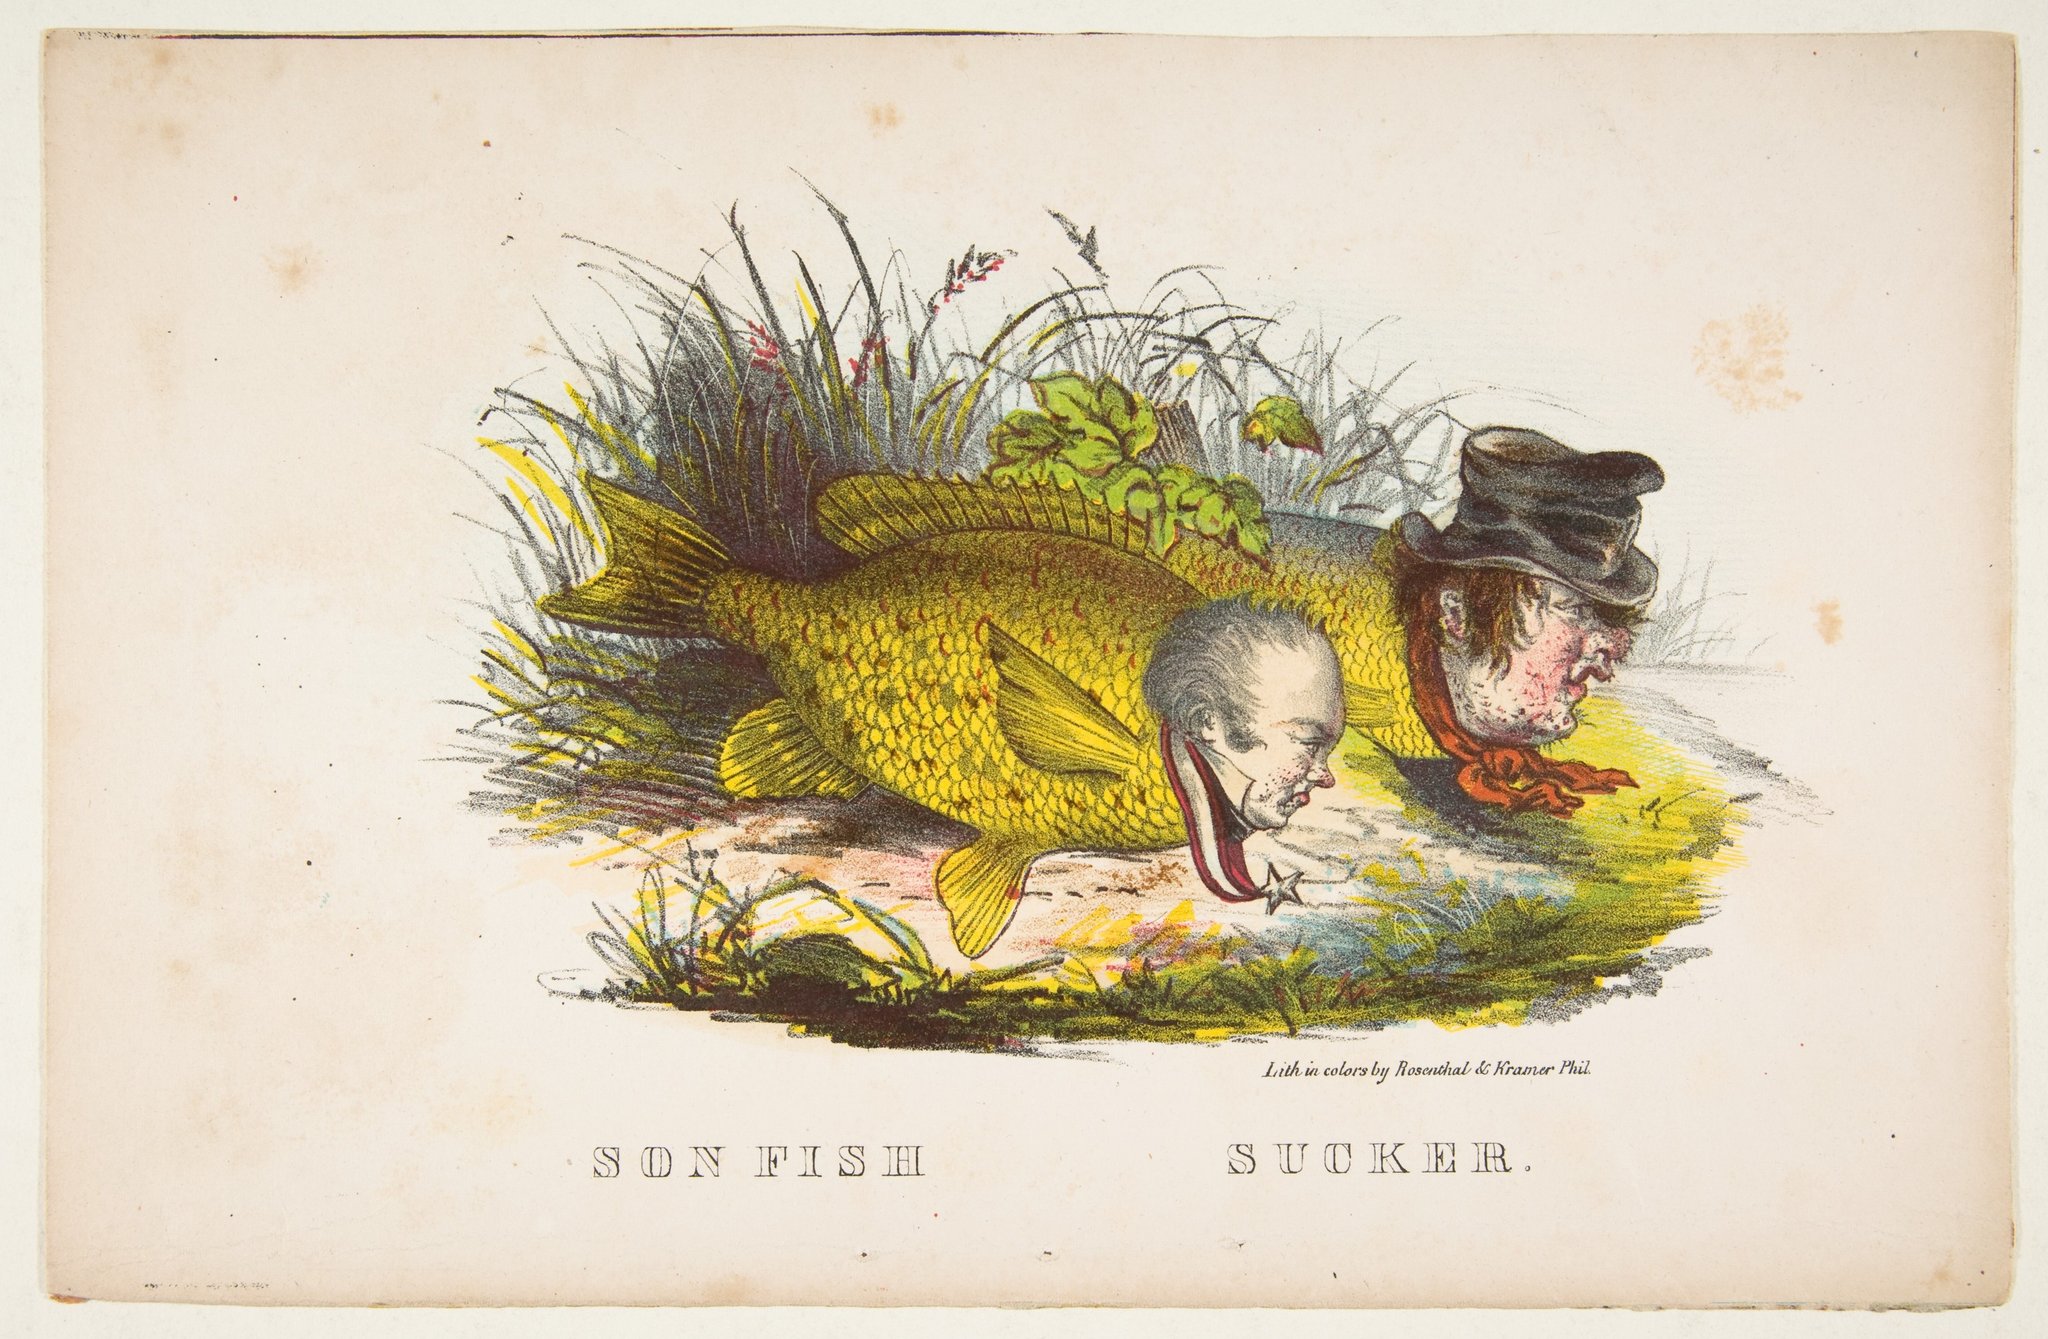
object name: print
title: Son Fish and Sucker, from "The Comic Natural History of the Human Race"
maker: henry louis stephens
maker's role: artist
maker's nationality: american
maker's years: 1824-1882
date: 1851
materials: watercolor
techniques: lithograph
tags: satire,fish